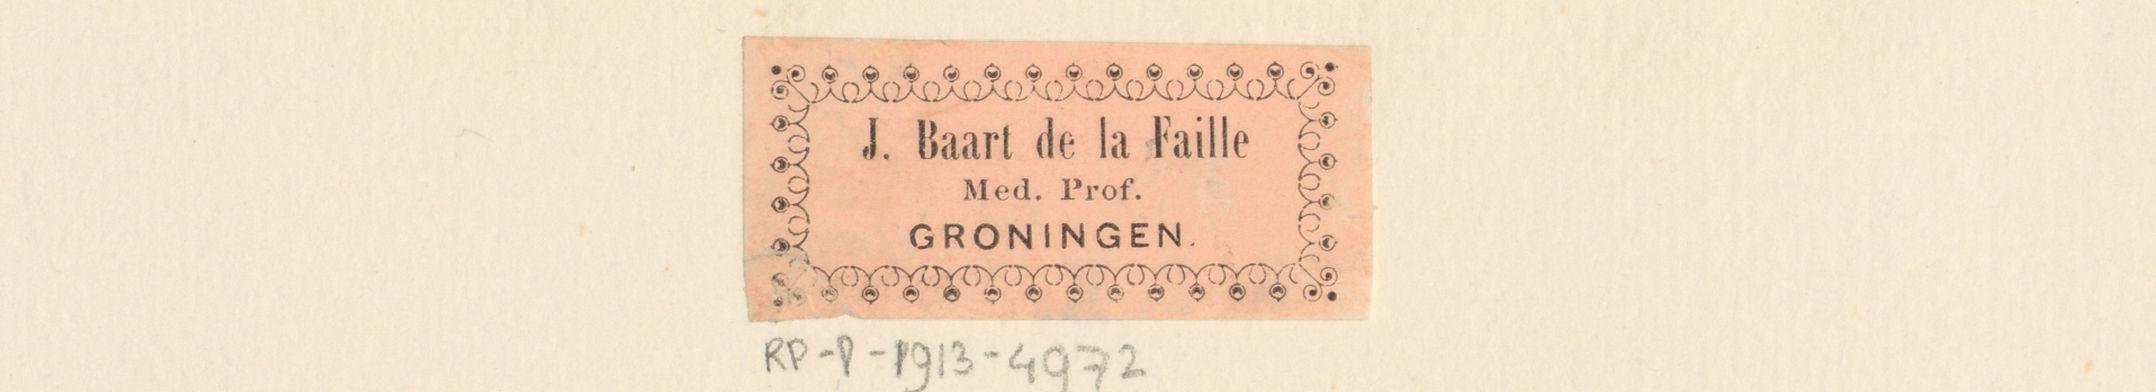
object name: bookplate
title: Ex libris van J. Baart de la Faille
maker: Anonymous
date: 1890-1913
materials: paper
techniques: printing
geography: netherlands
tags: jacob iv baart de la faille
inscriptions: collector's mark: Lugt 2233, collector's mark: Lugt 2760